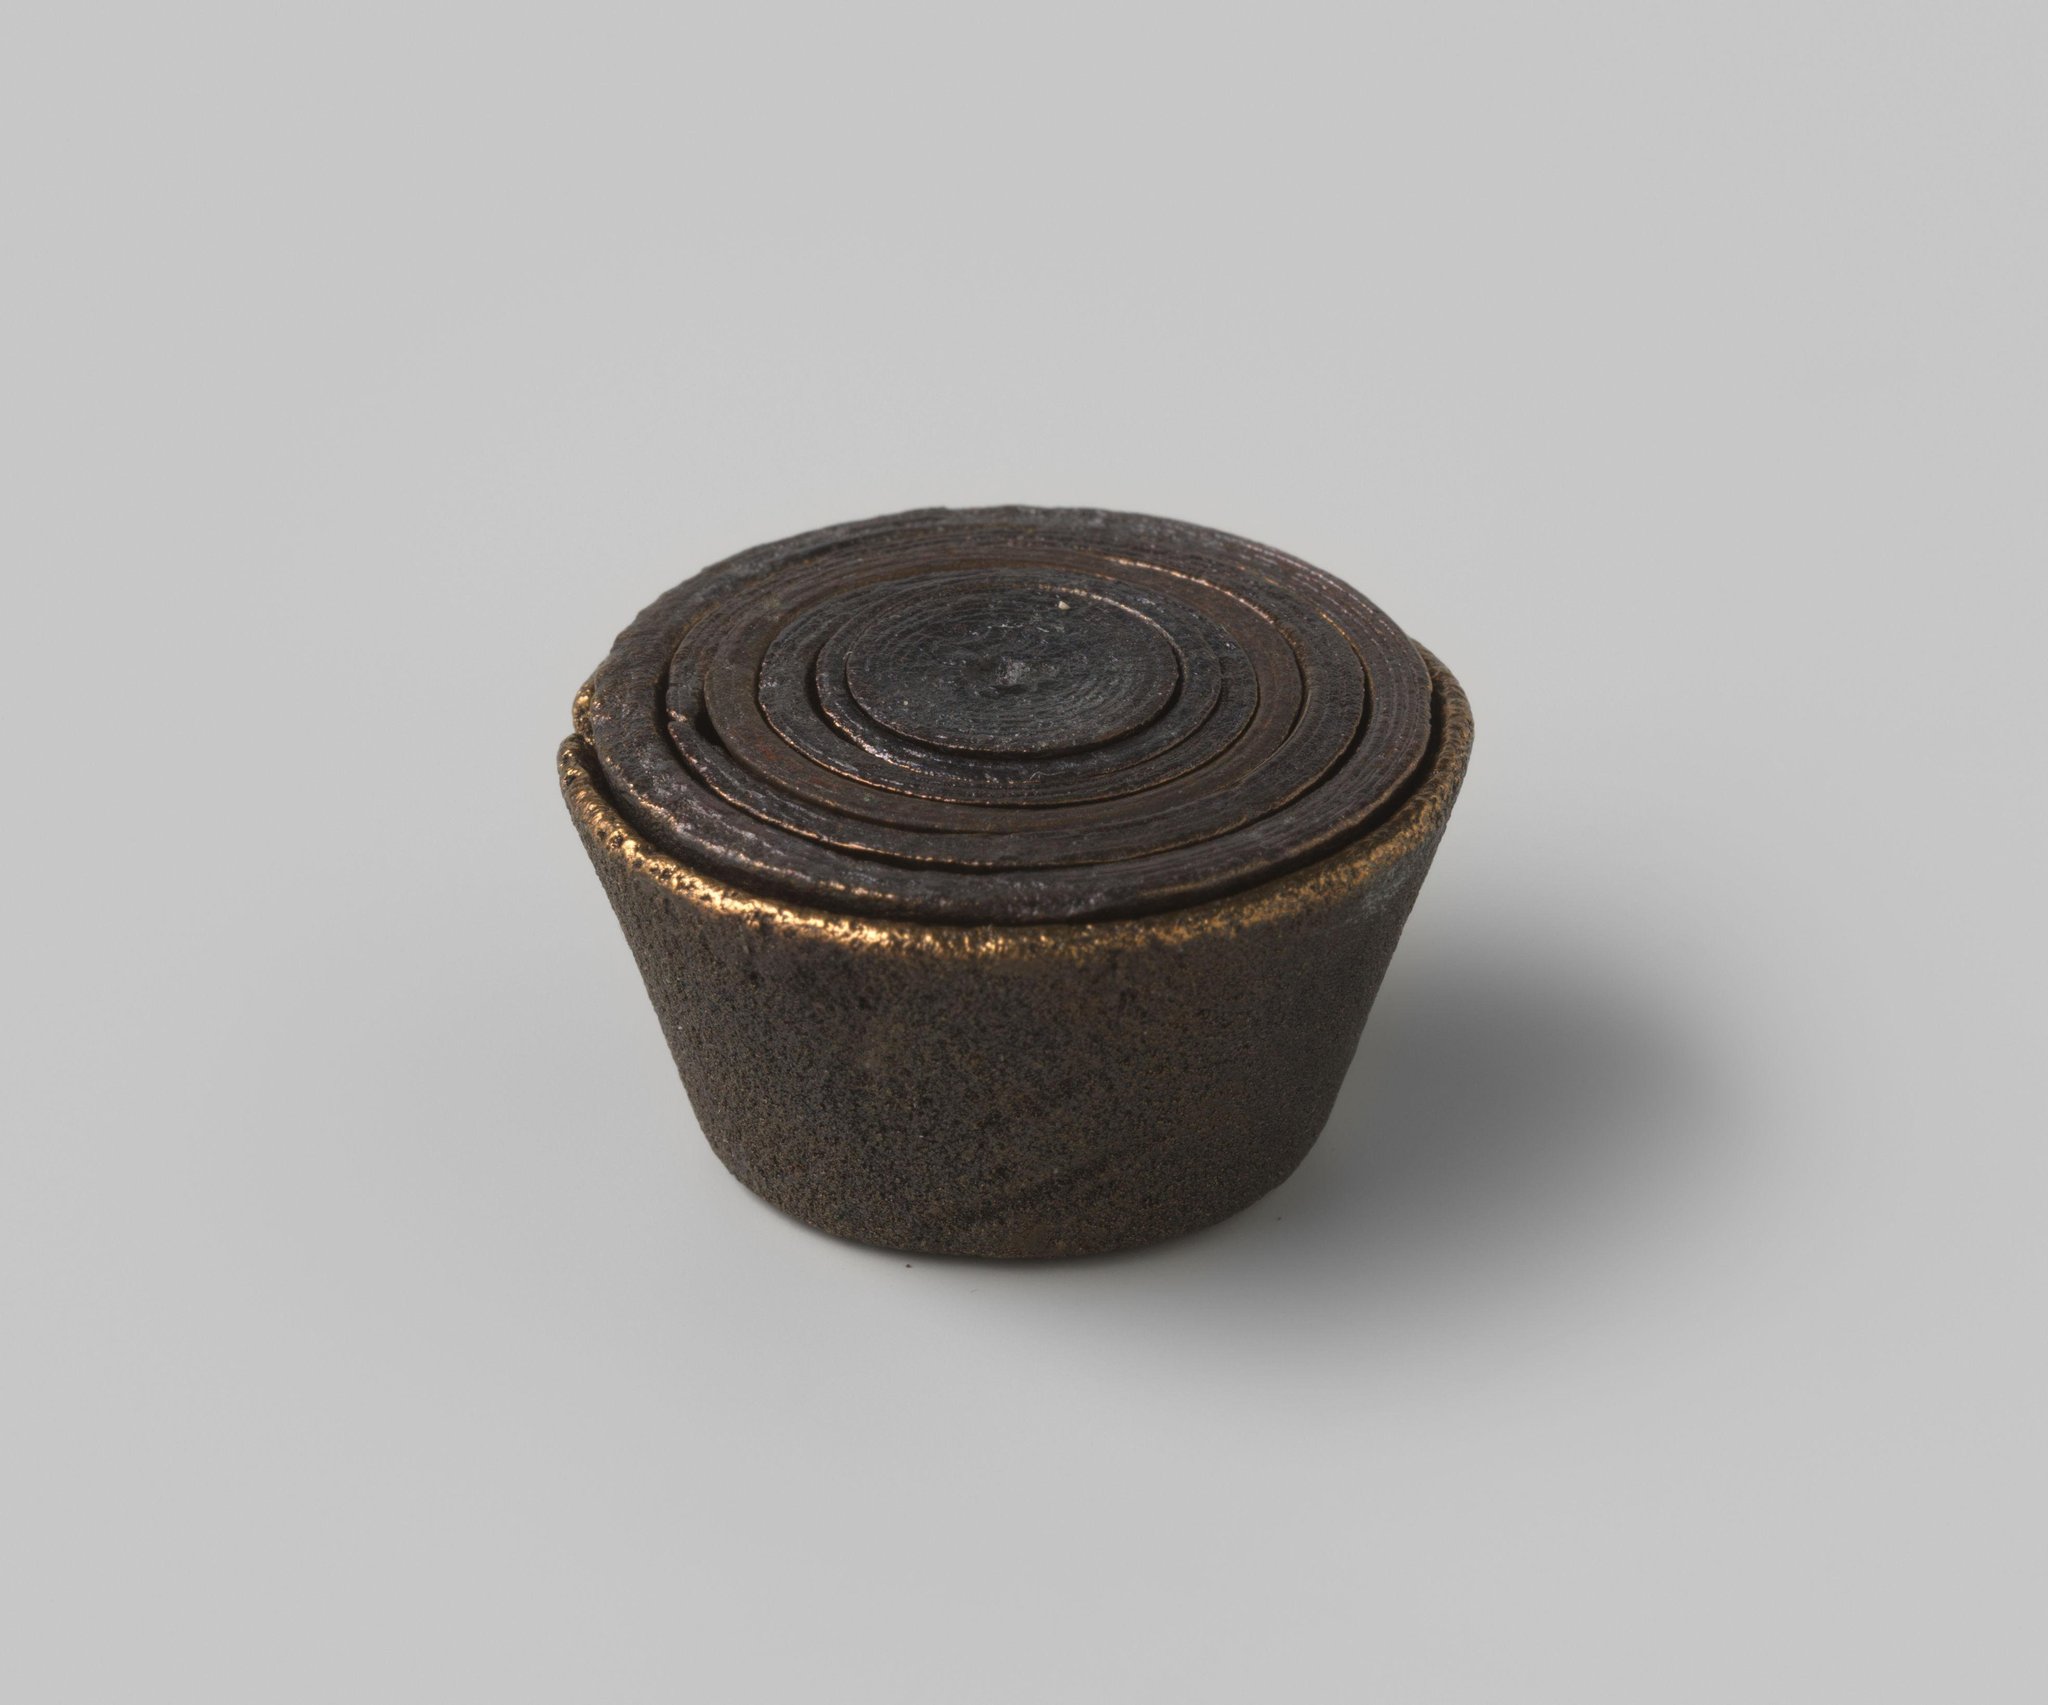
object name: sluitgewicht, pijlgewicht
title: Sluitgewicht uit het wrak van de Oost-Indiëvaarder Hollandia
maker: Anonymous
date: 1700-1743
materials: copper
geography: netherlands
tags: verenigde oostindische compagnie, hollandia (schip), annet